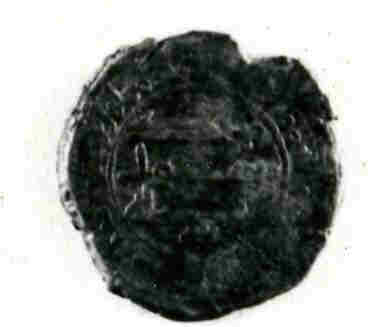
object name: coin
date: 169-785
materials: copper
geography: iran